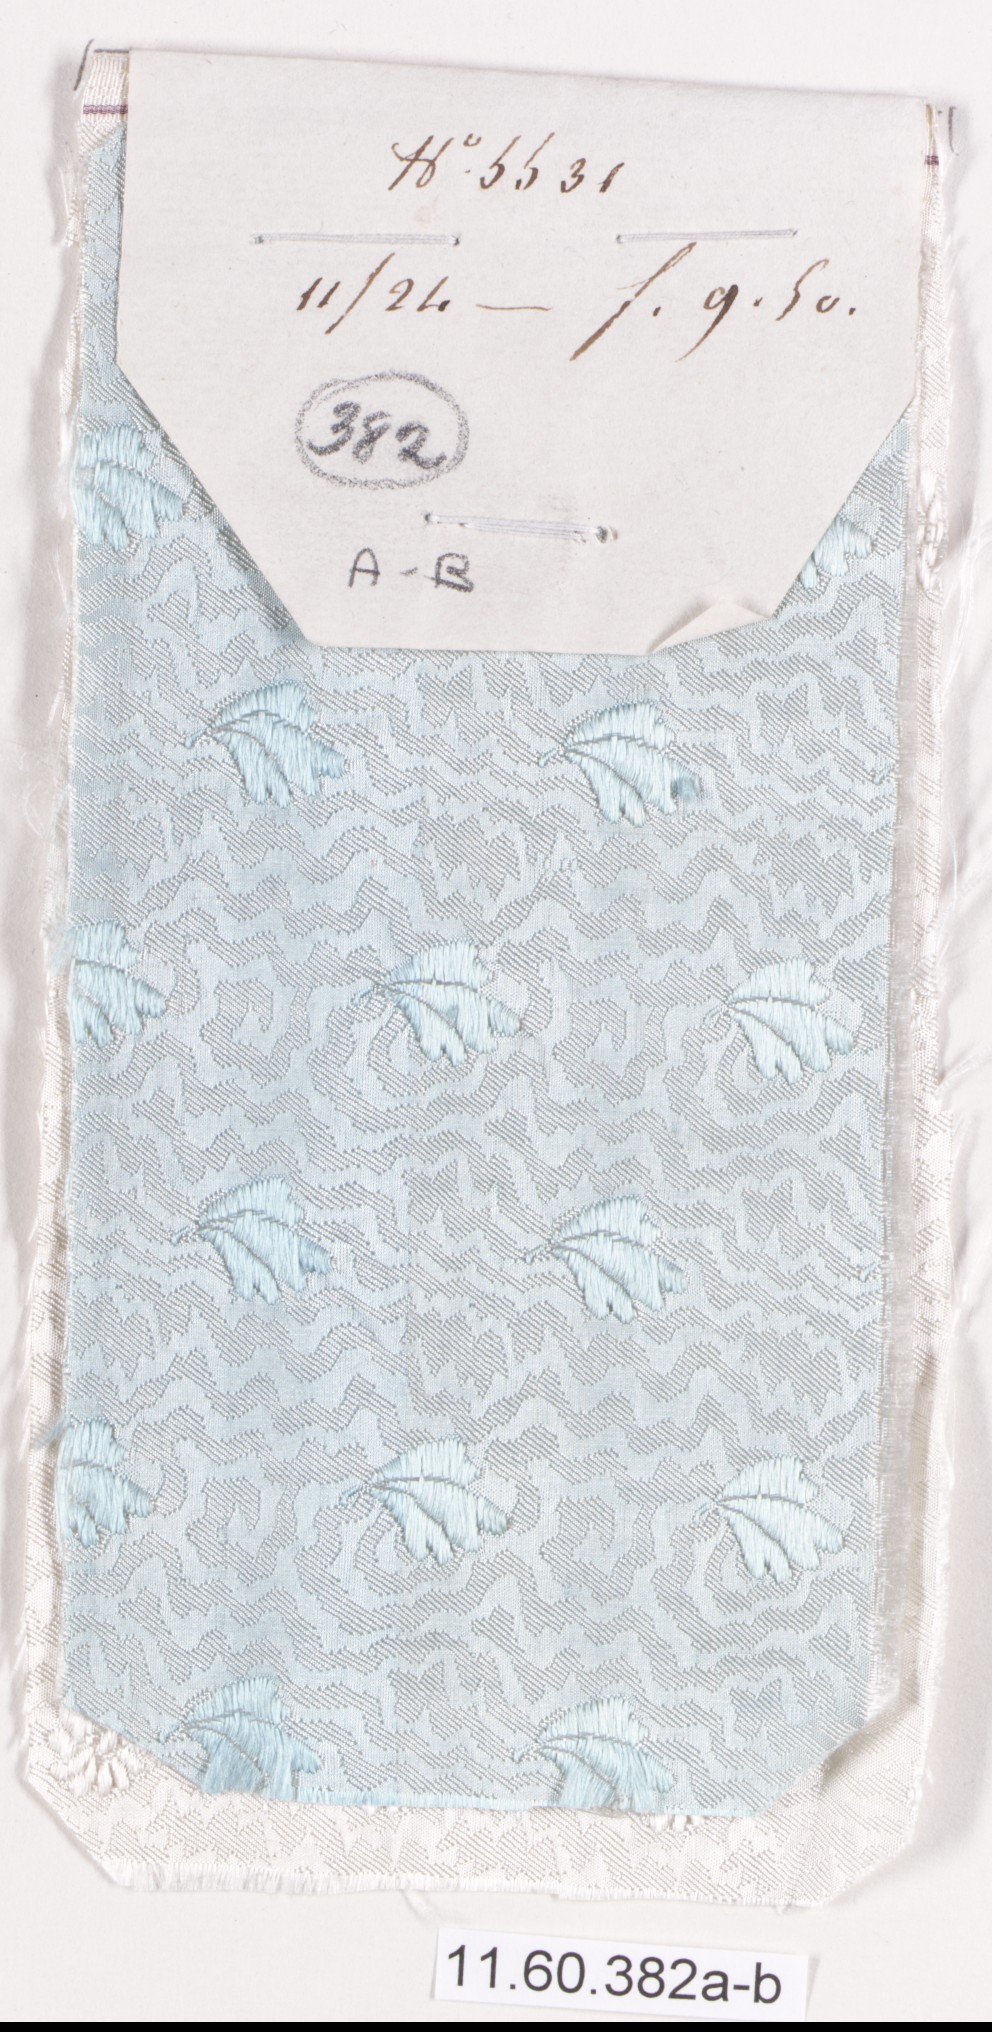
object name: fragment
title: Fragments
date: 1801-1900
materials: silk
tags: leaves